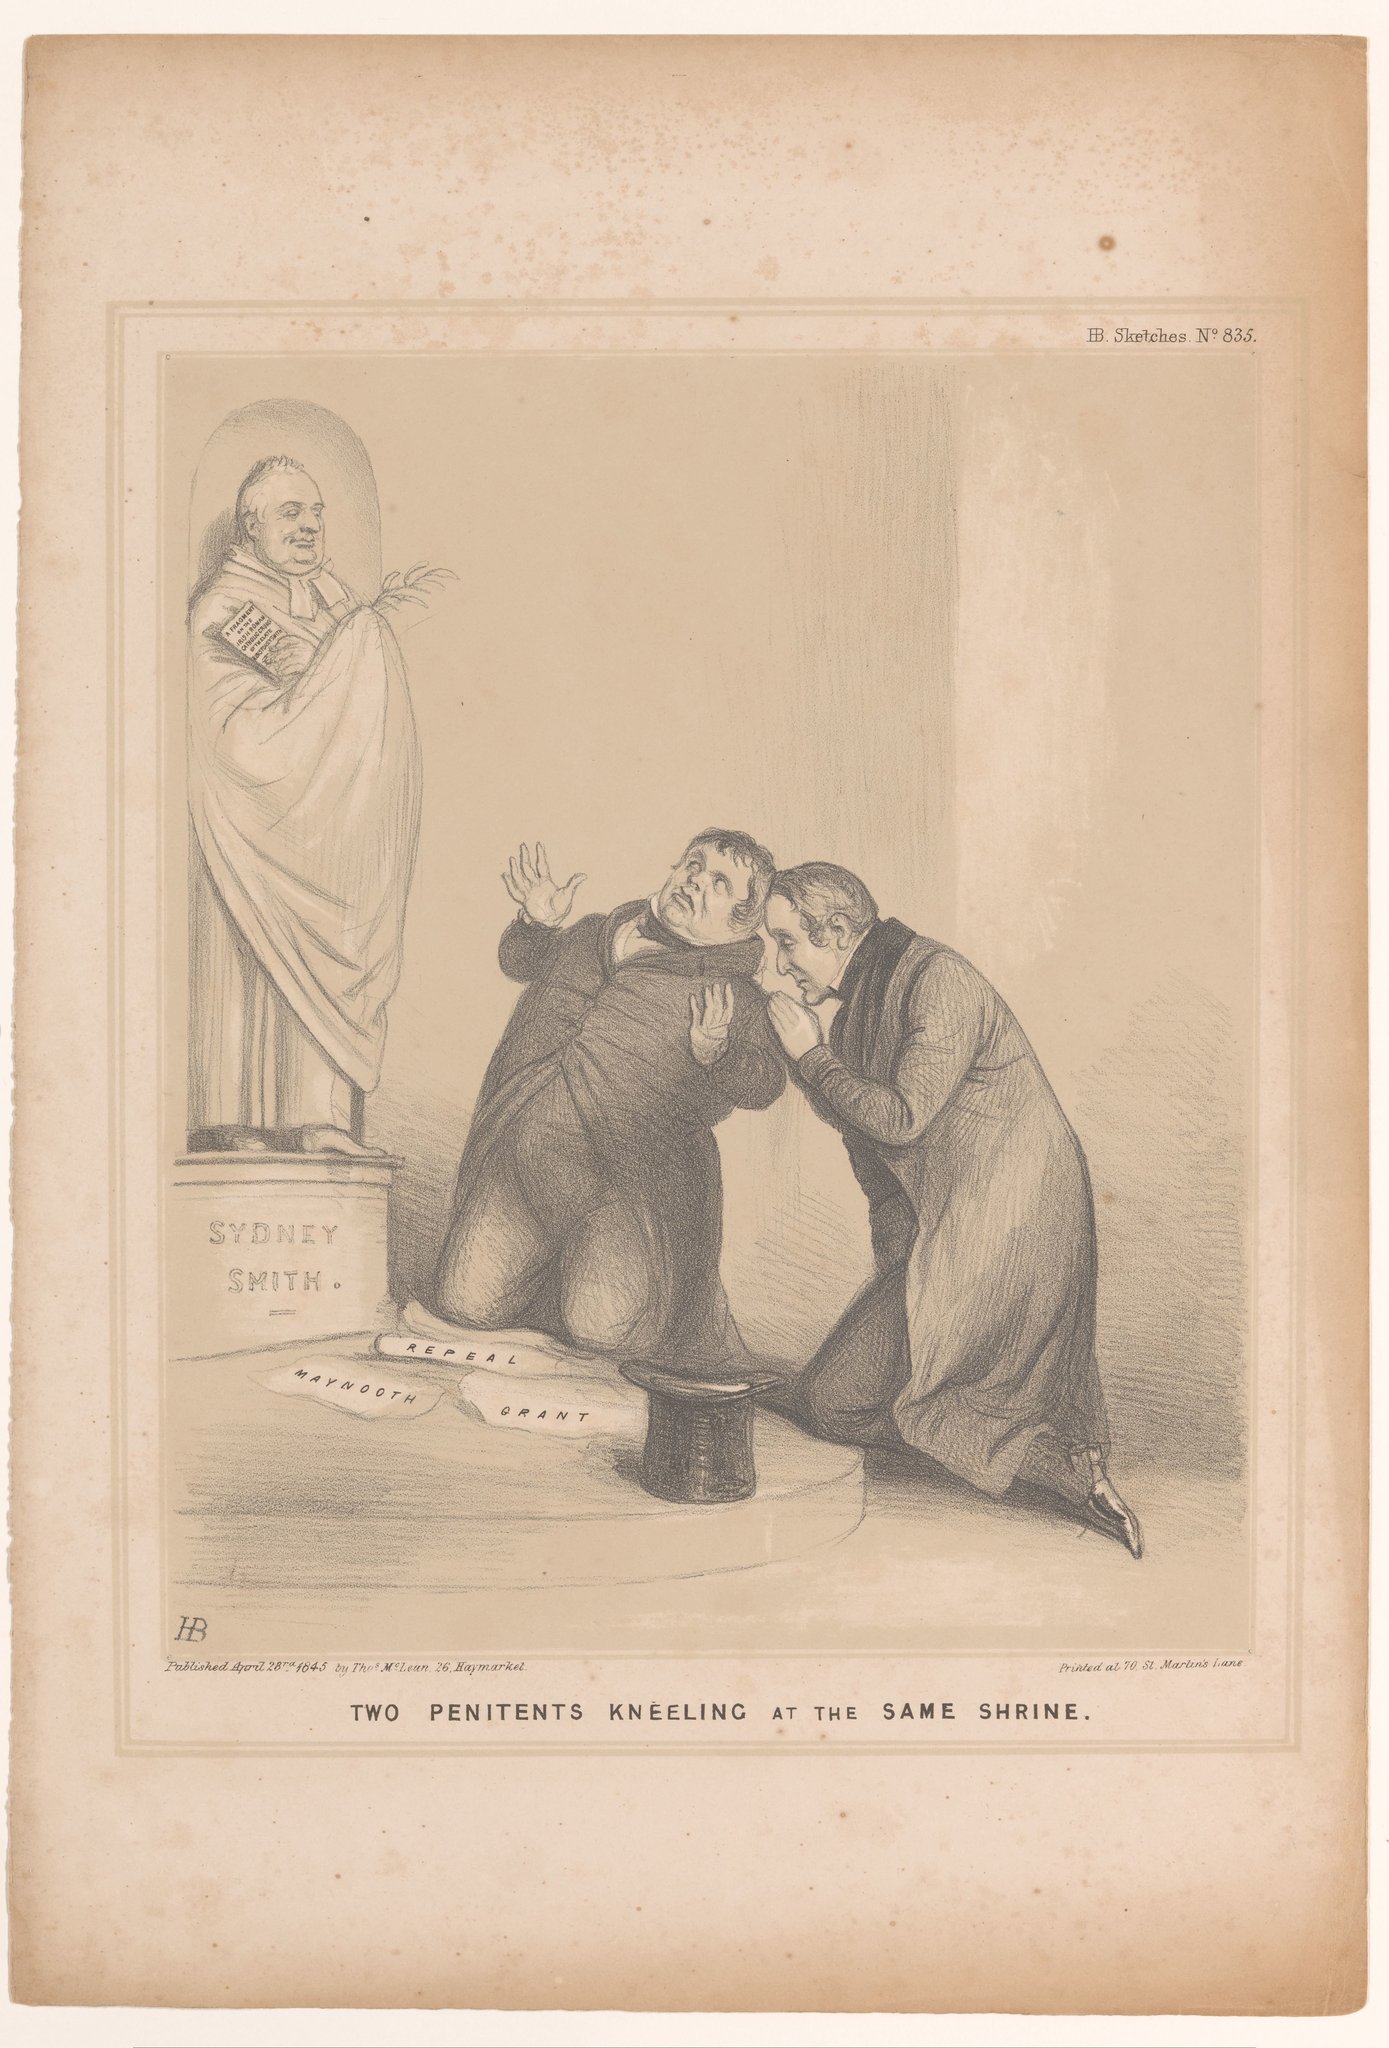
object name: print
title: HB Sketches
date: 1845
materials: paper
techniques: tone lithography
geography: england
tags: london, penitence, repentance; 'penitenza', 'pentimento', 'pentimento de'peccati', 'purgatione de peccati' (ripa), piece of sculpture, reproduction of a piece of sculpture, political caricatures and satires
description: Spotprent uit 1845 met premier Robert Peel en Daniel O'Connell als boetedoeners knielend voor een standbeeld van dominee Sydney Smith. Uitgegeven als nr. 835 in de serie HB Sketches.